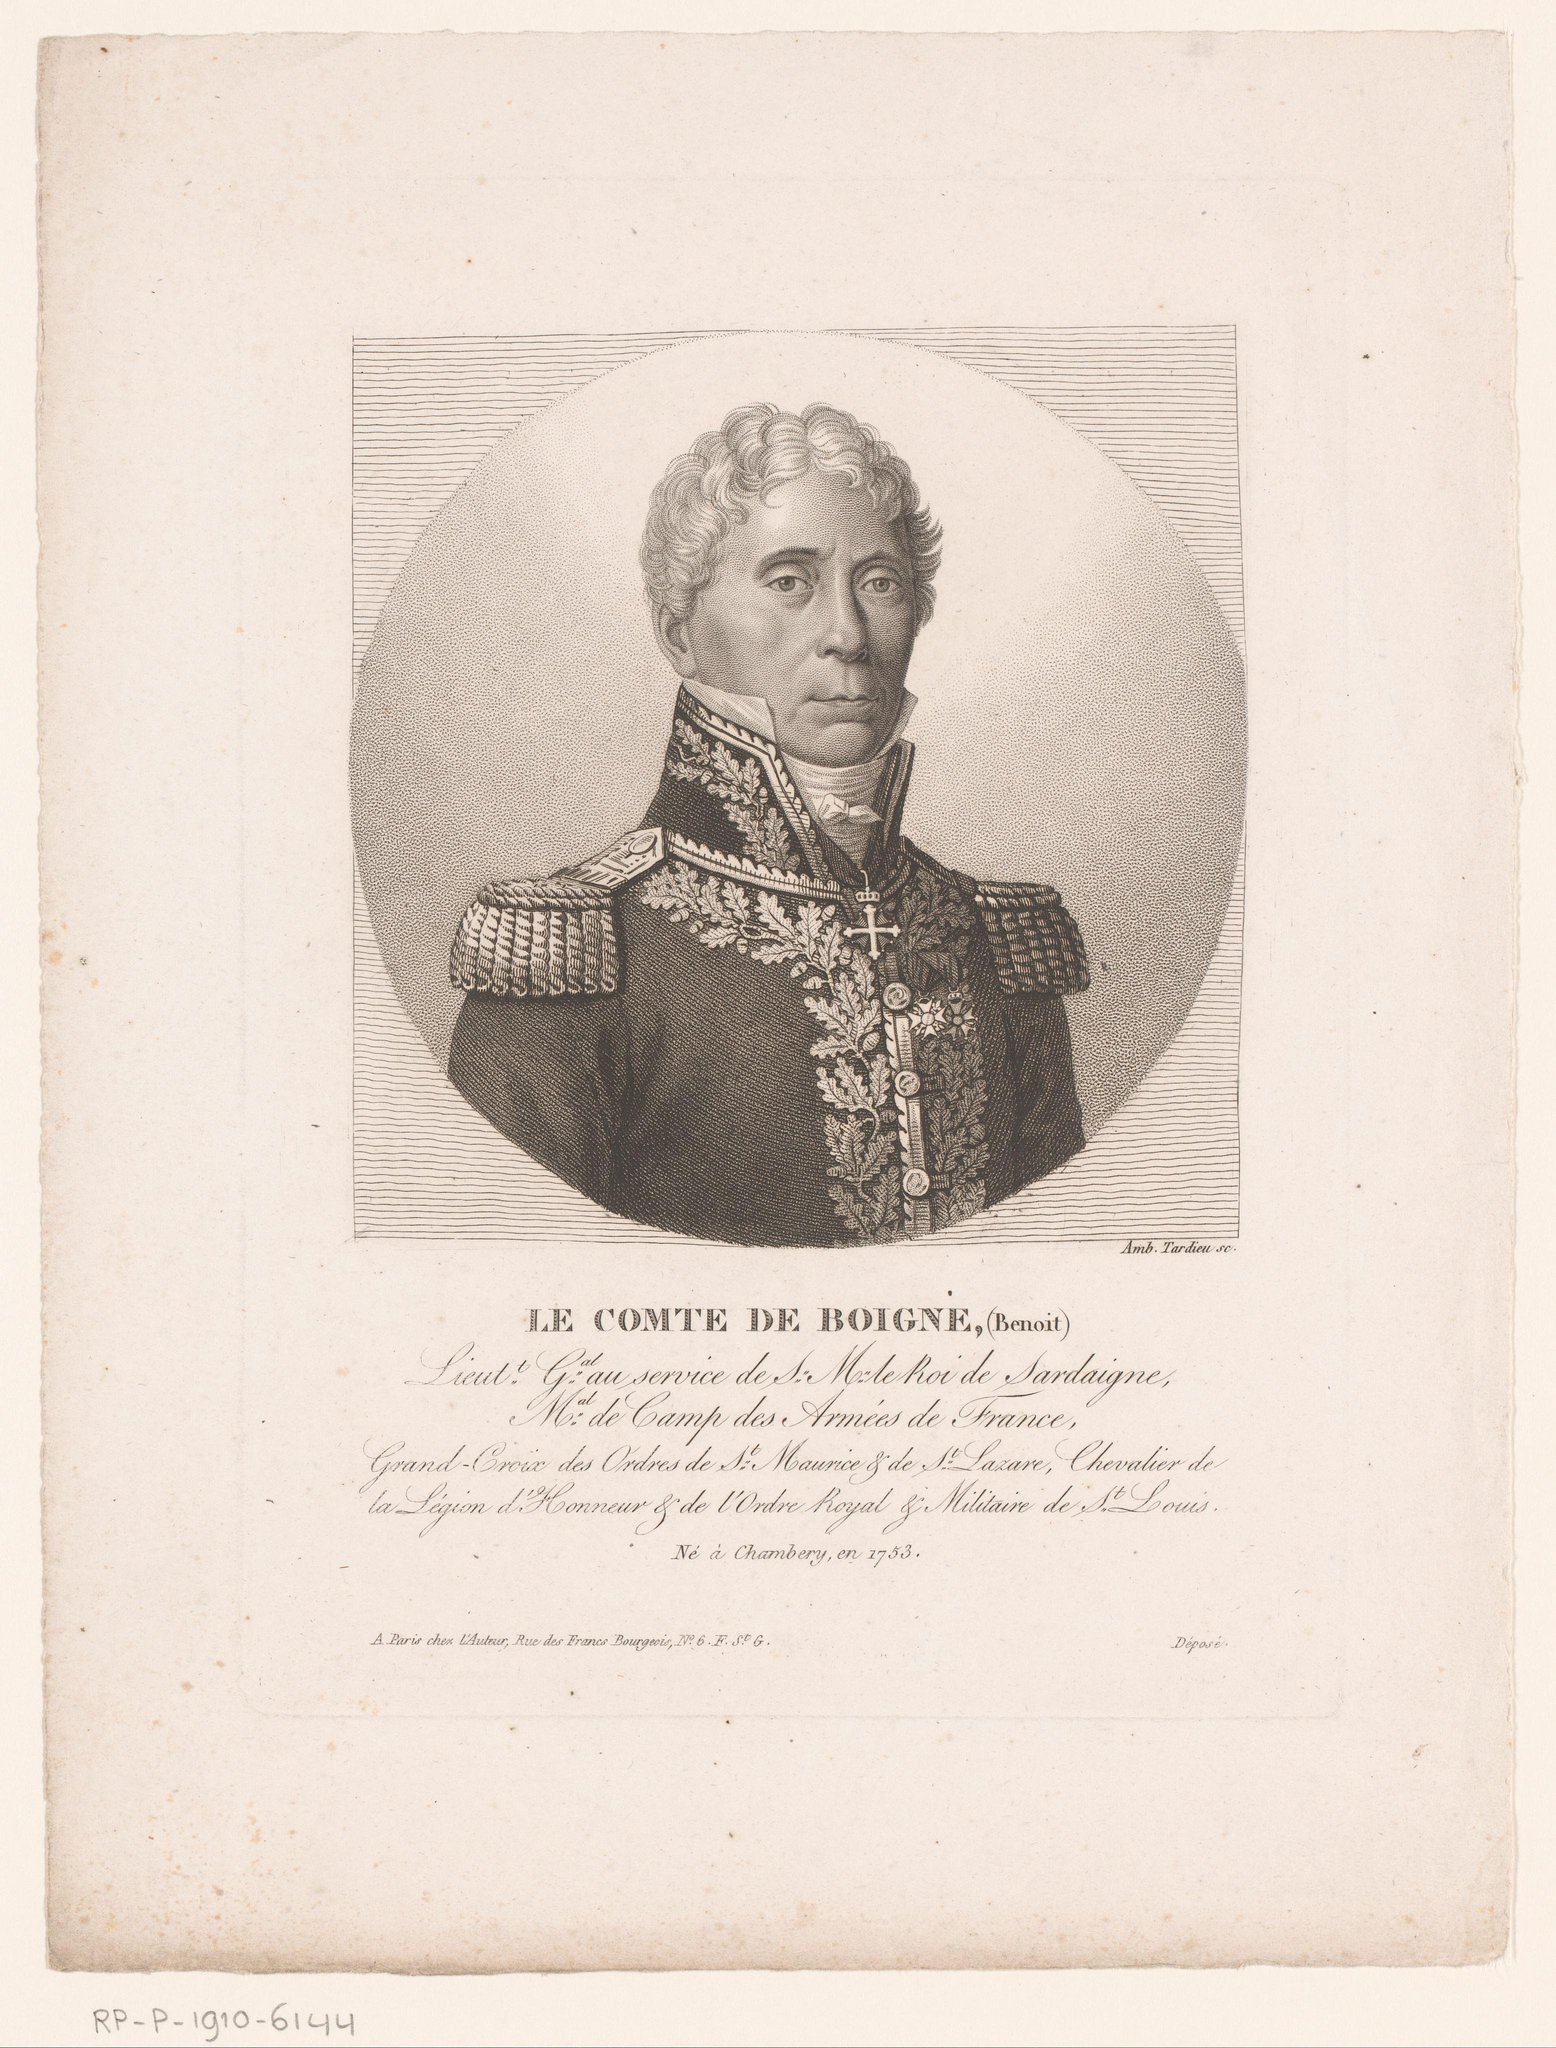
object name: print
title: Portret van Benoît de Boigne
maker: ambroise tardieu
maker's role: print maker, printer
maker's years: 1788-1841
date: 1822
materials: paper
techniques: engraving, roulette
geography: paris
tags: earl, politician, historical persons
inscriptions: collector's mark: Lugt 2228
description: Onder zijn beeltenis biografische gegevens.